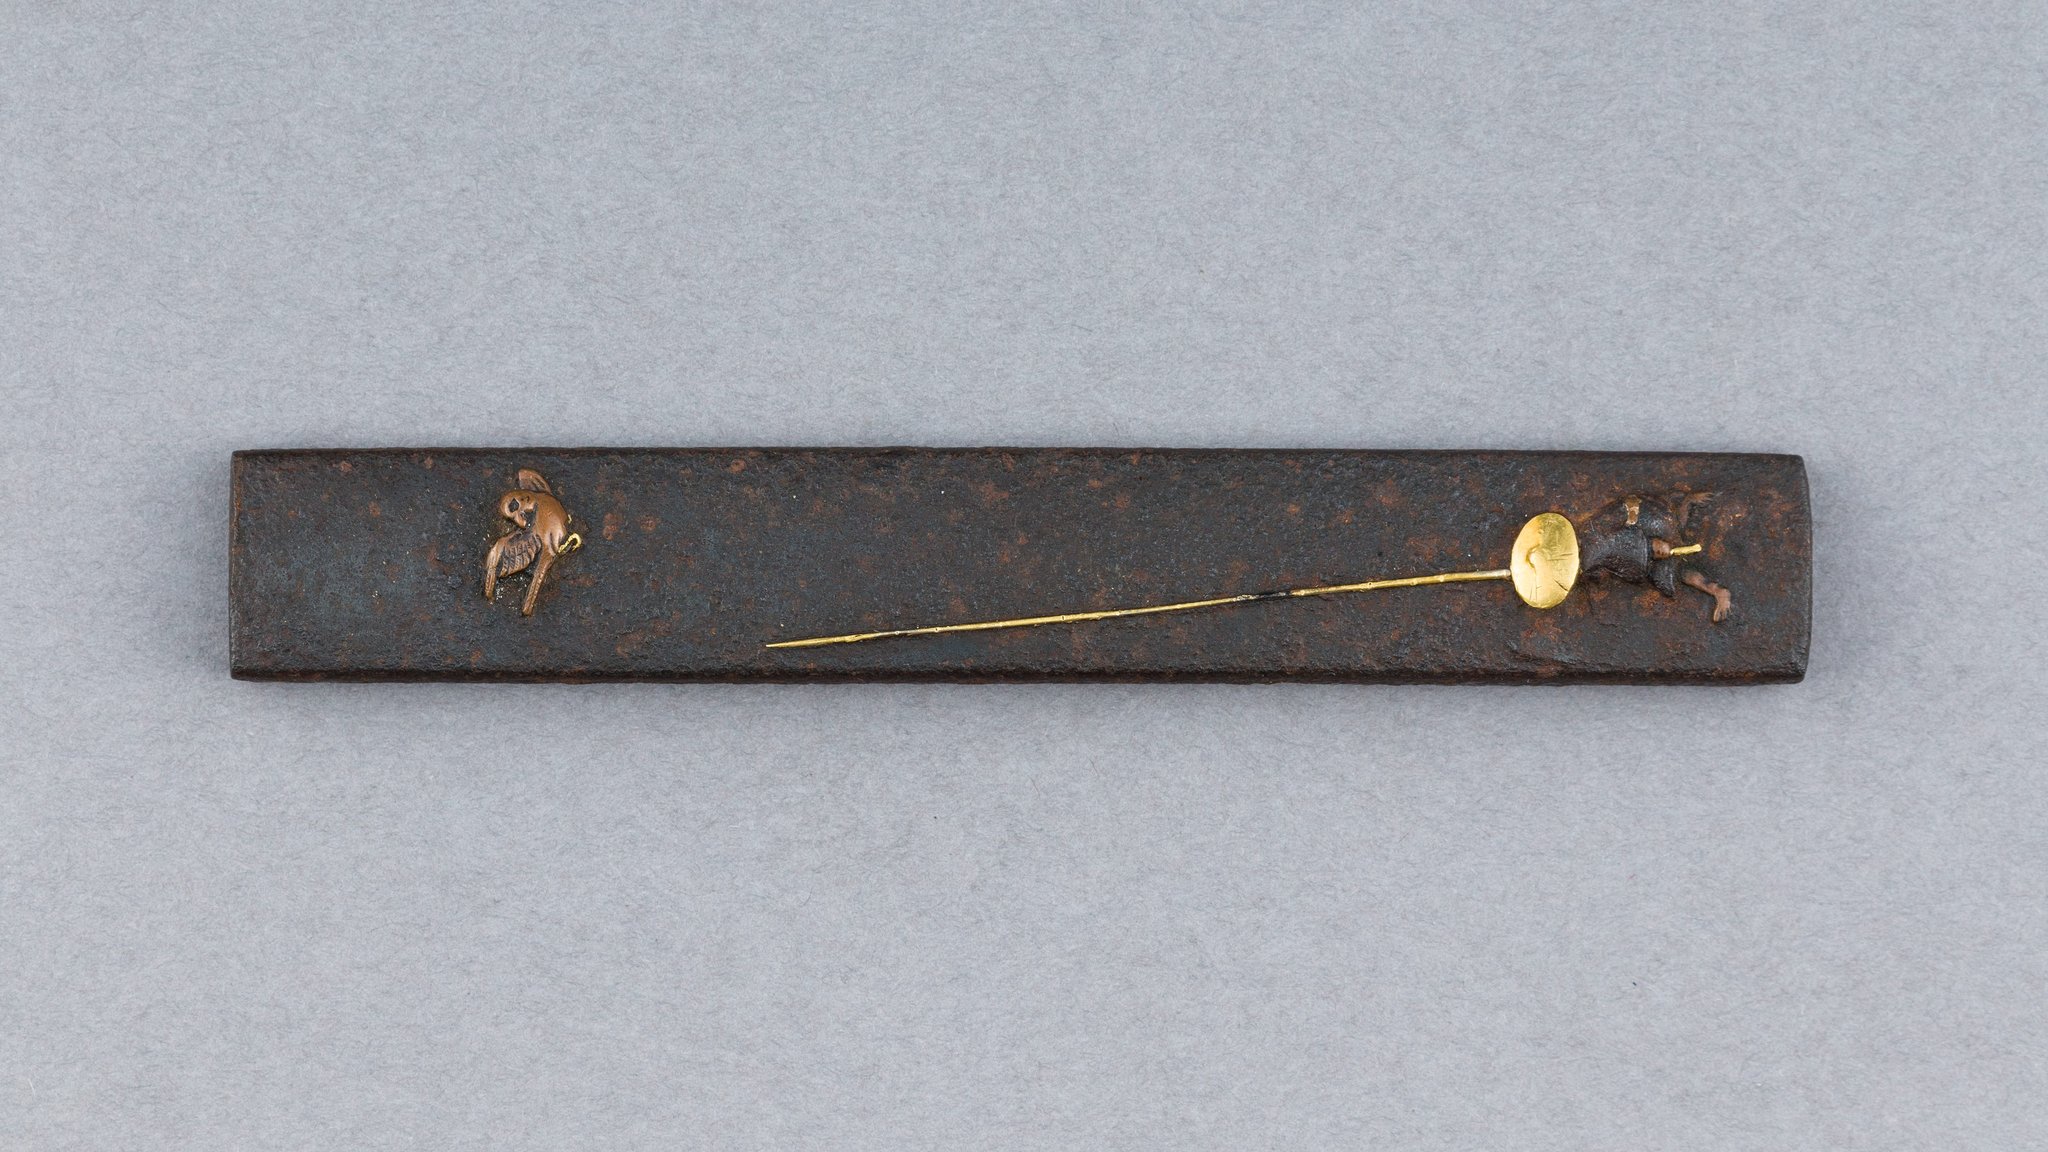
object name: knife handle kozuka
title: Knife Handle (Kozuka)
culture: japanese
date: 1615-1868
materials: copper, silver alloy, gold, iron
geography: japan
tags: birds